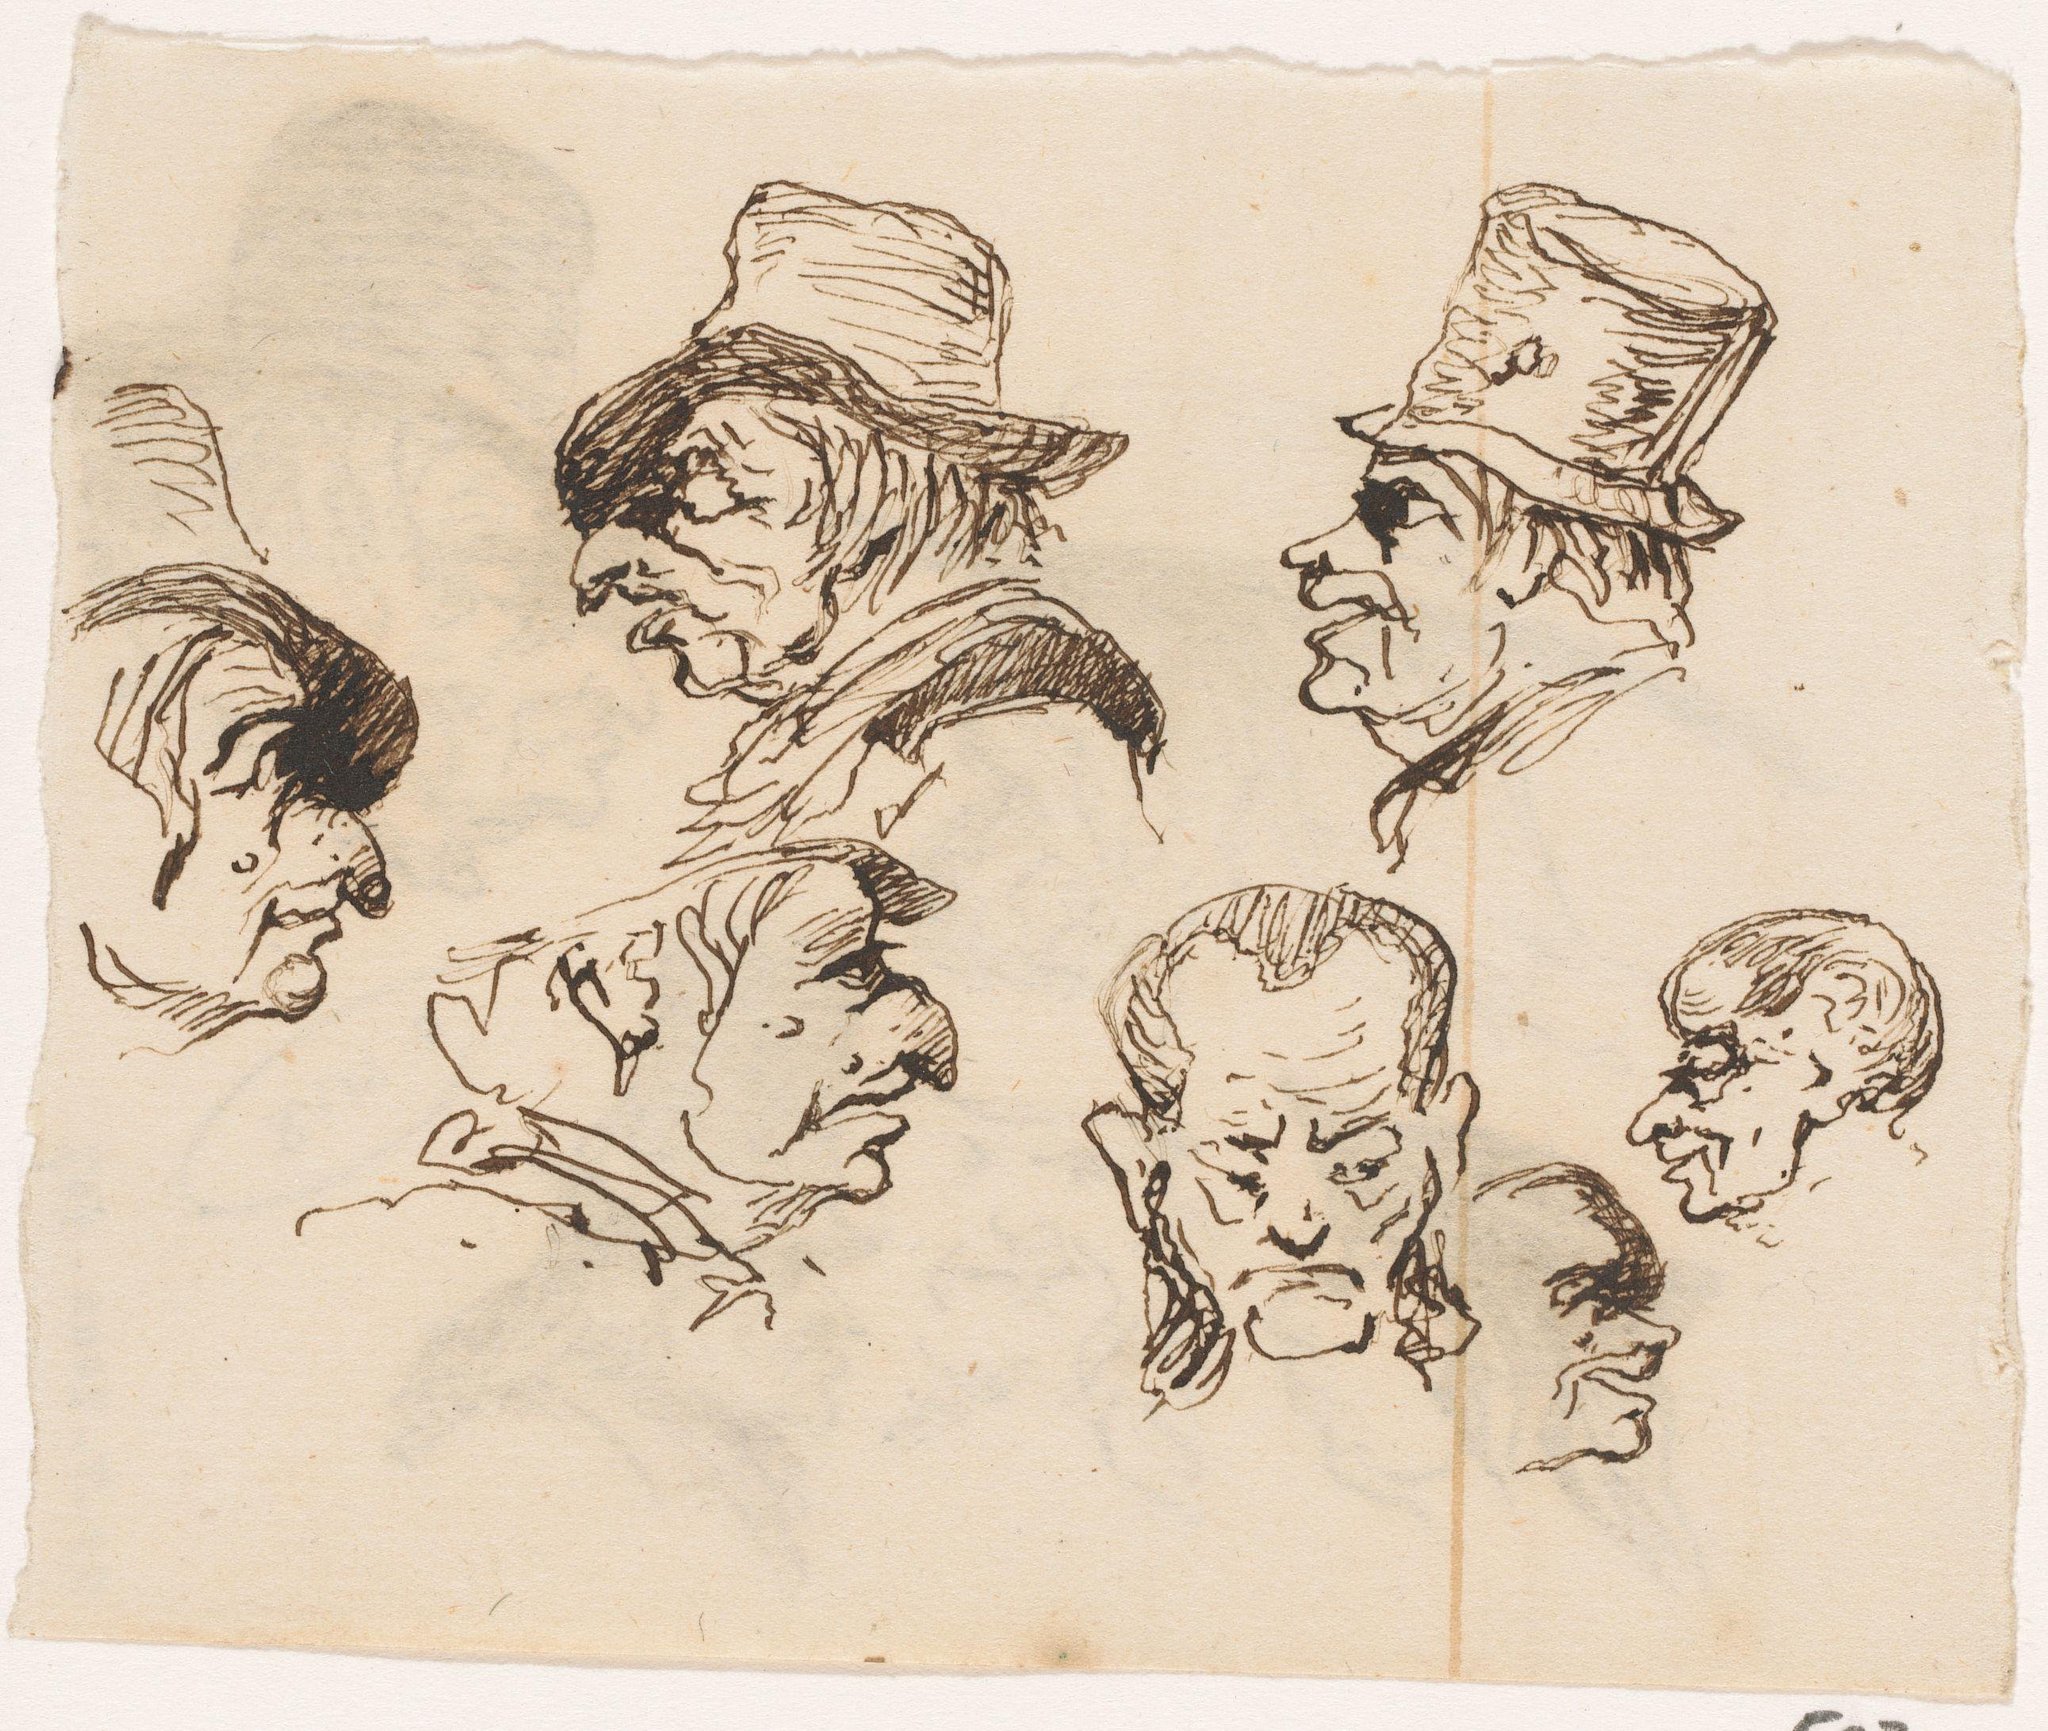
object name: drawing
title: Koppen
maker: johannes tavenraat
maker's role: draughtsman, painter, print maker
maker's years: 1809-1881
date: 1840-1880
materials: ink, paper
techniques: pen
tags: caricatures (human types)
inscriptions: collector's mark: Lugt 2228